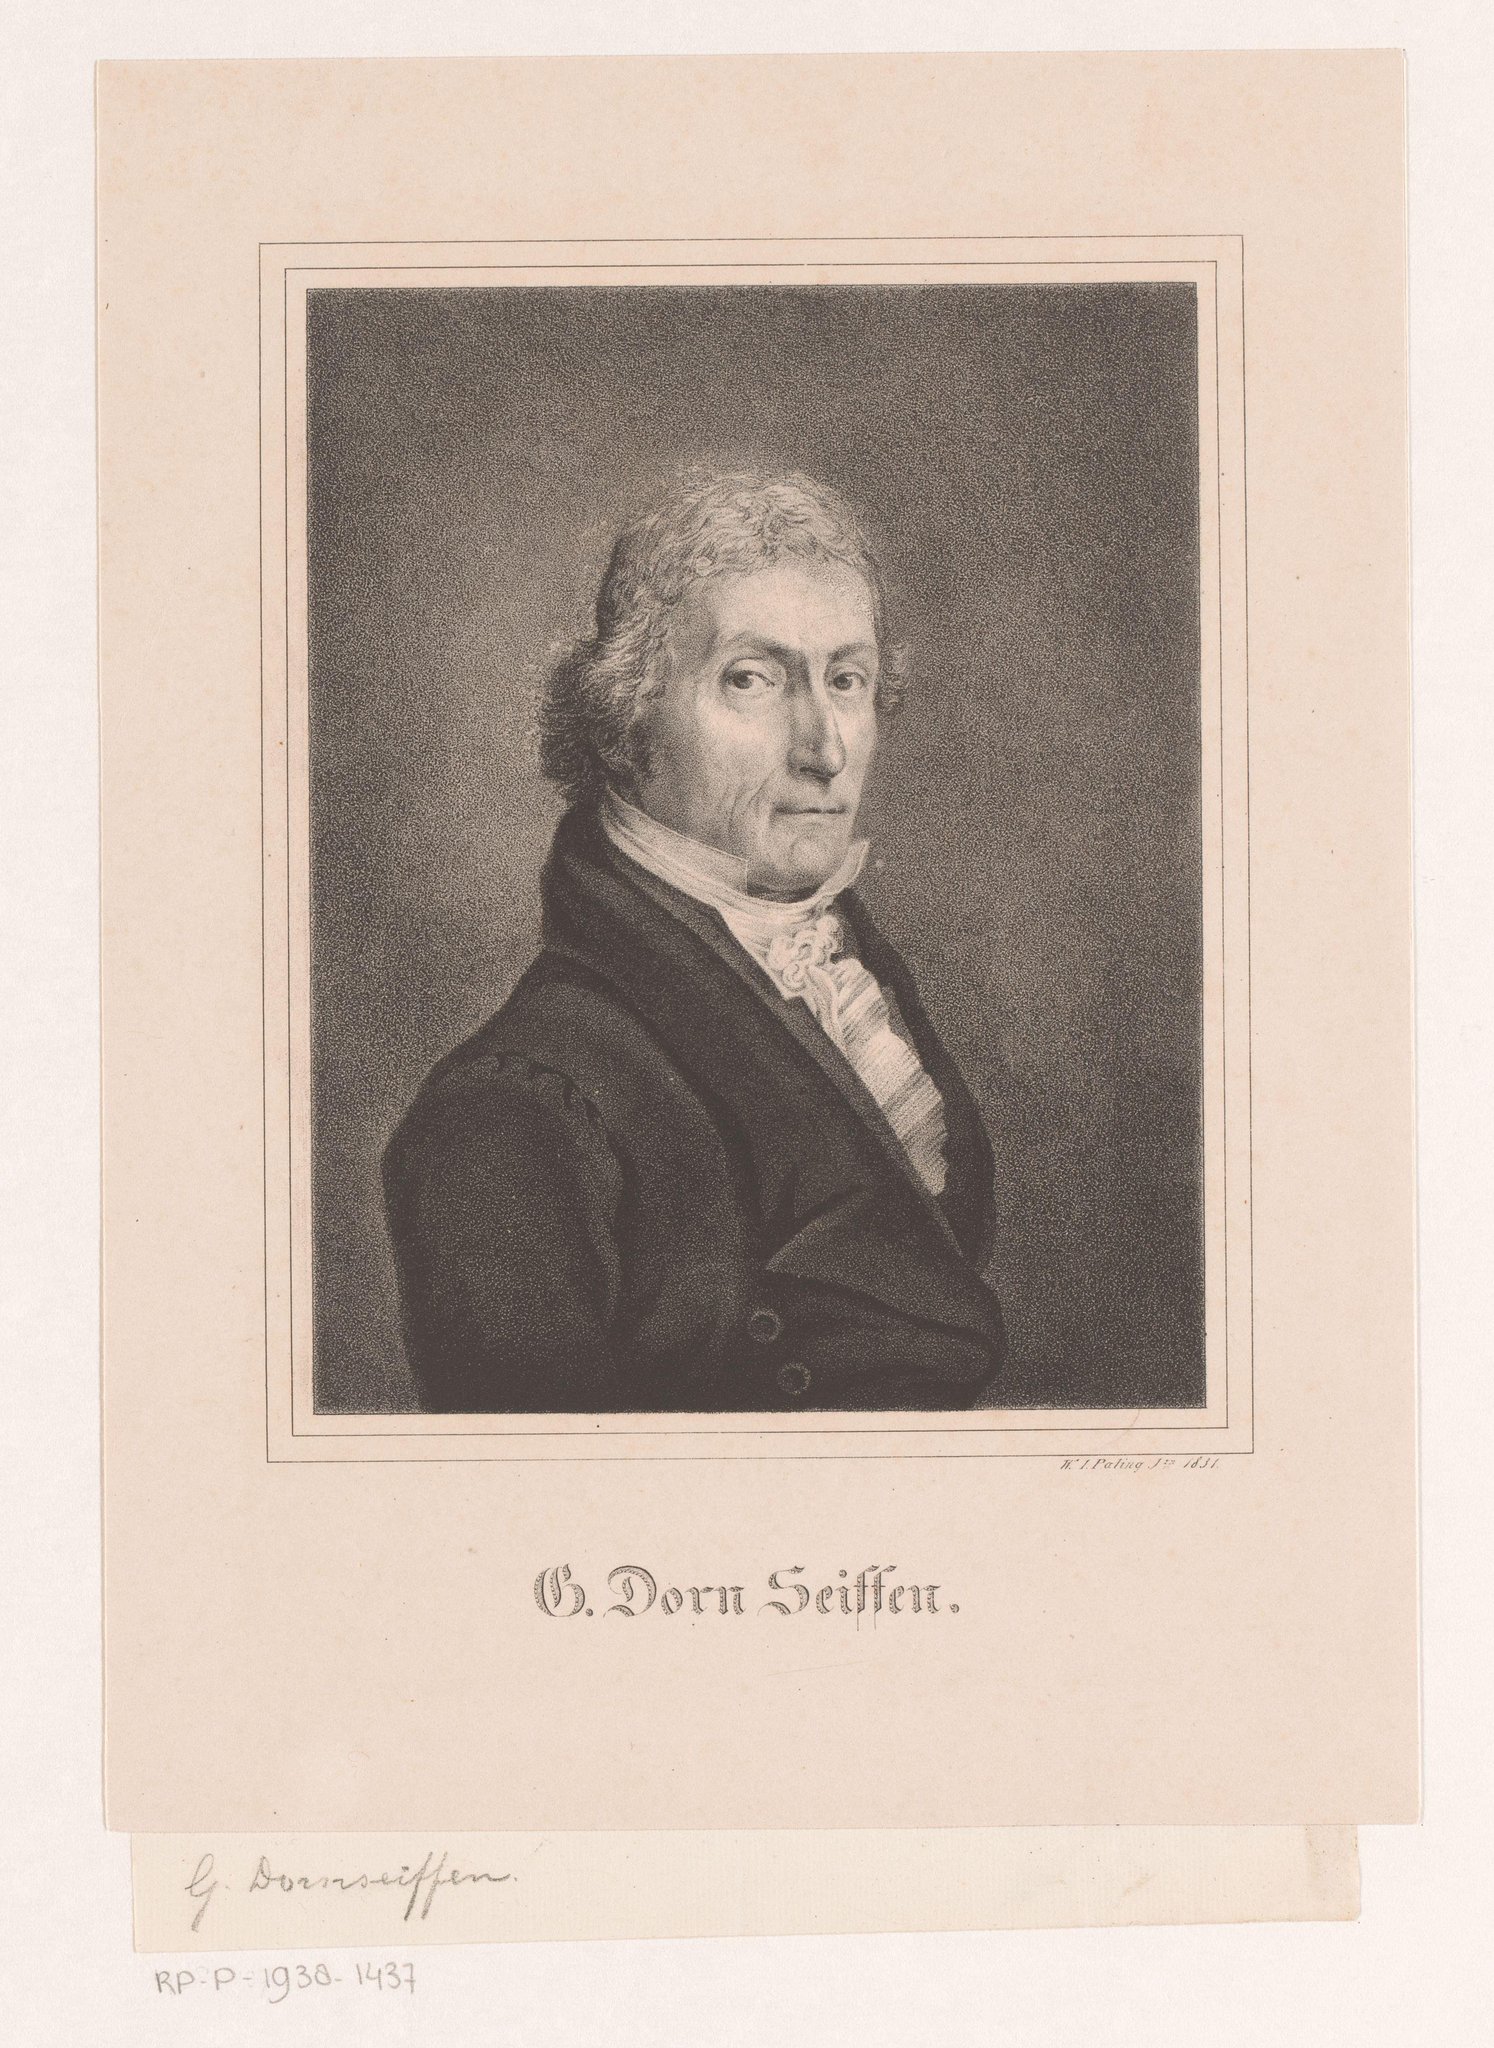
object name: print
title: Portret van Gerardus Dorn Seiffen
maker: willem jan paling jz.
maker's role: print maker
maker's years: 1776-1848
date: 1831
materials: paper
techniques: lithograph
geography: netherlands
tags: the hague, gerardus dorn seiffen, historical persons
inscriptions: collector's mark: Lugt 2228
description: Bijgevoegd een gedrukte tekst over de prent, geschreven door A. Simons.